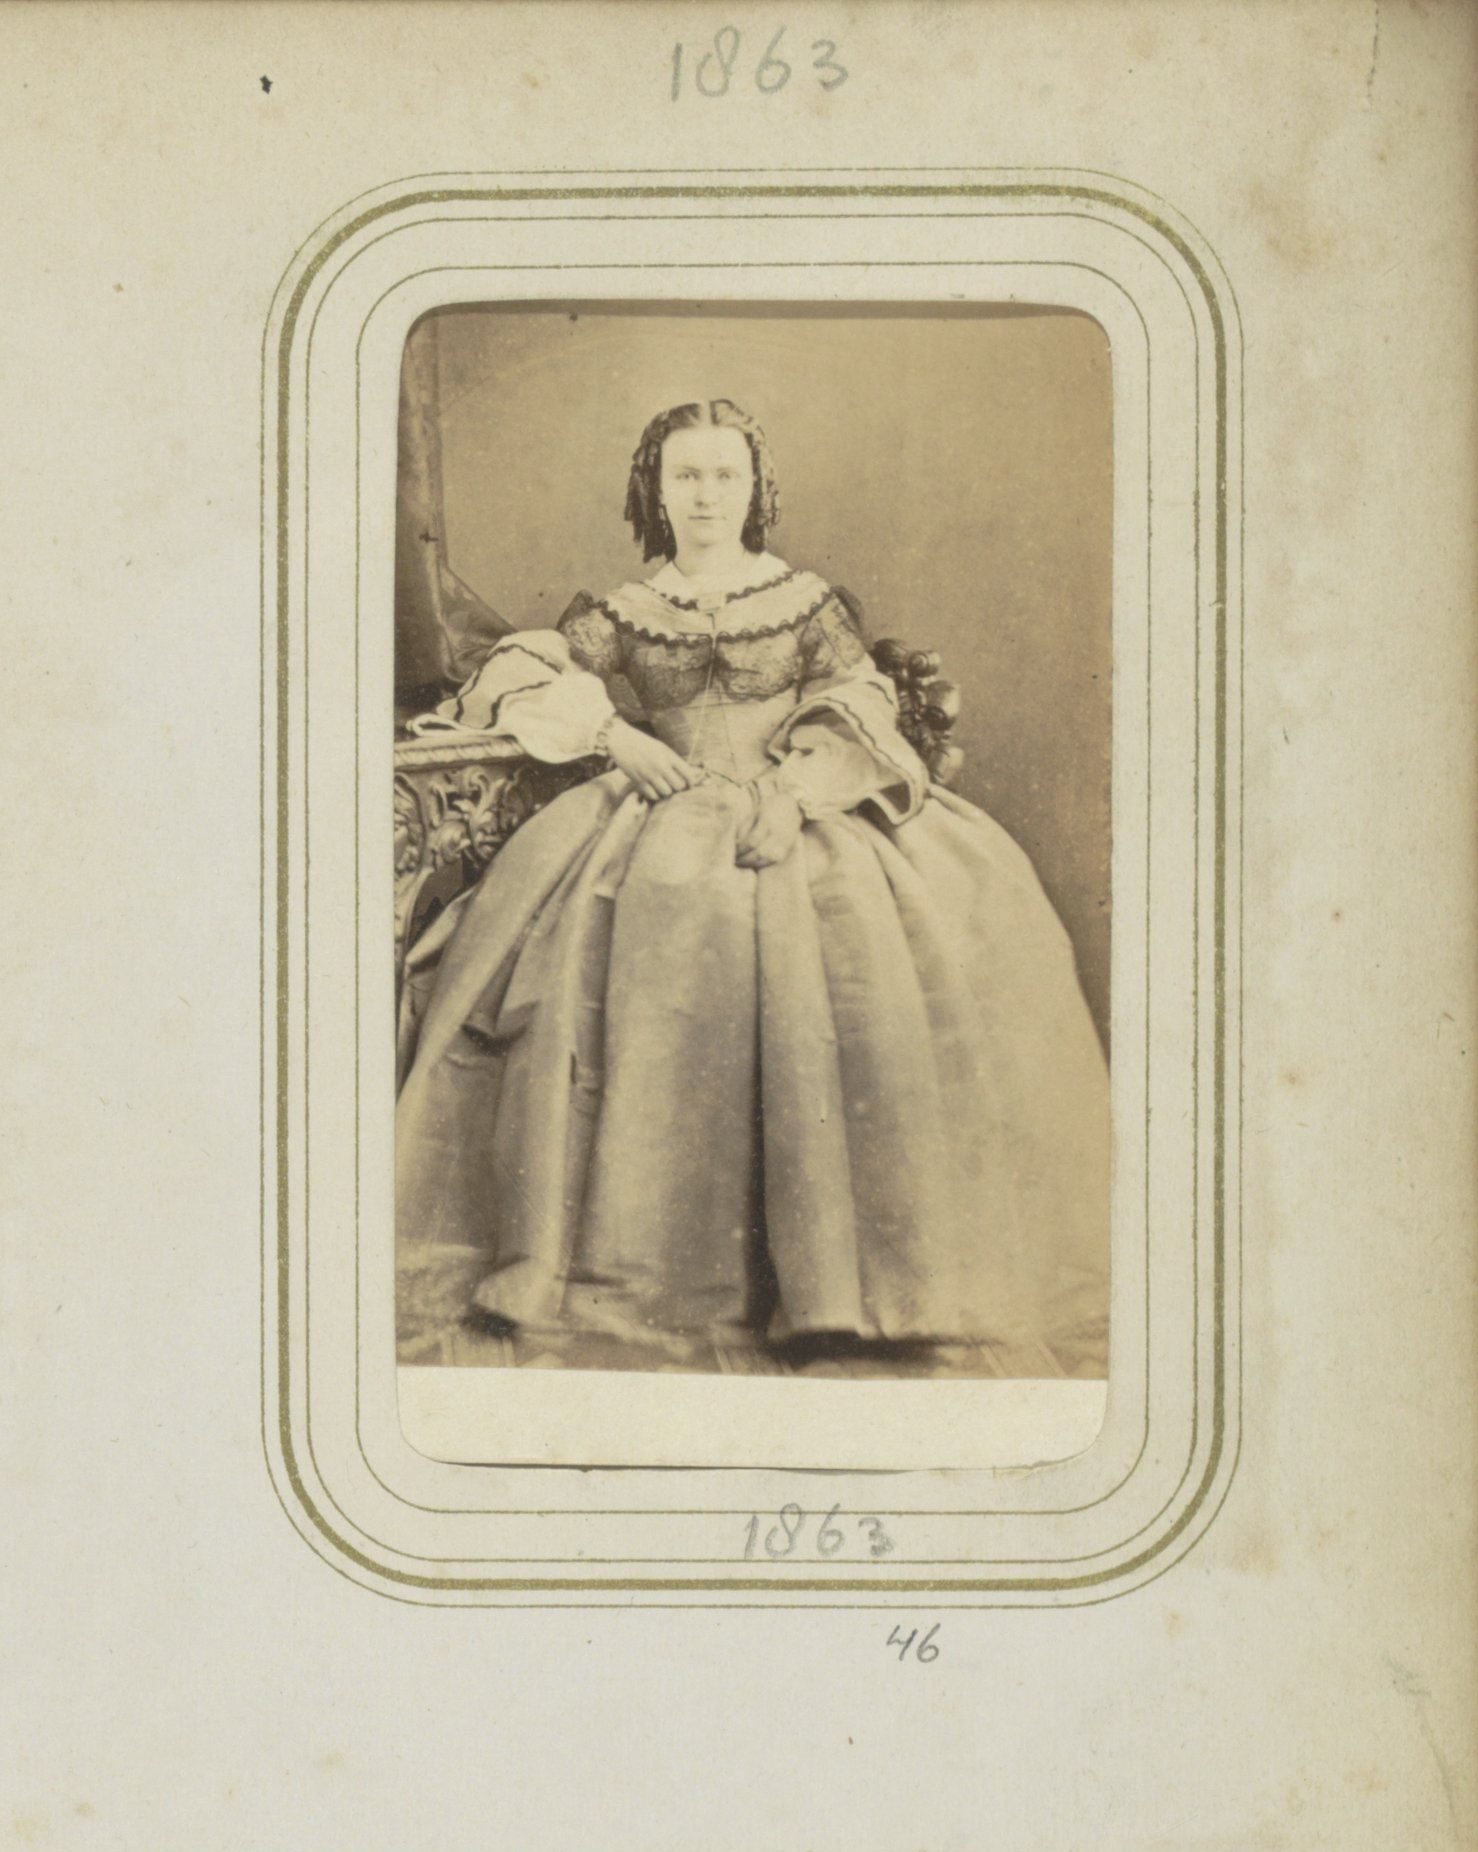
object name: carte de visite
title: Portret van mevrouw J.C. Sauveur in een geplooide jurk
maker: a. böeseken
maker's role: fotograaf, lithograaf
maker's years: 1834-1919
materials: cardboard, photographic support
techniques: albumen print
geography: rotterdam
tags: studio requisites ~ photographer, historical persons, styles of hairdress - aa - ~ women, clothing for the upper part of the body, family, relationship, descent, dress, gown, rotterdam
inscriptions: inscription: ‘Den Mevr. H.W.F. Ligtenberg Batavia van Mevrouw J.C. Sauveur Rotterdam gezonden 8 Aug. 1863’, date: ‘1863’, address: ‘Rotterdam’, date: ‘8 Aug. 1863’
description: Onderdeel van Familiealbum van H.W.F. Ligtenberg en L.M. Swart met 149 foto's en cartes-de-visite.